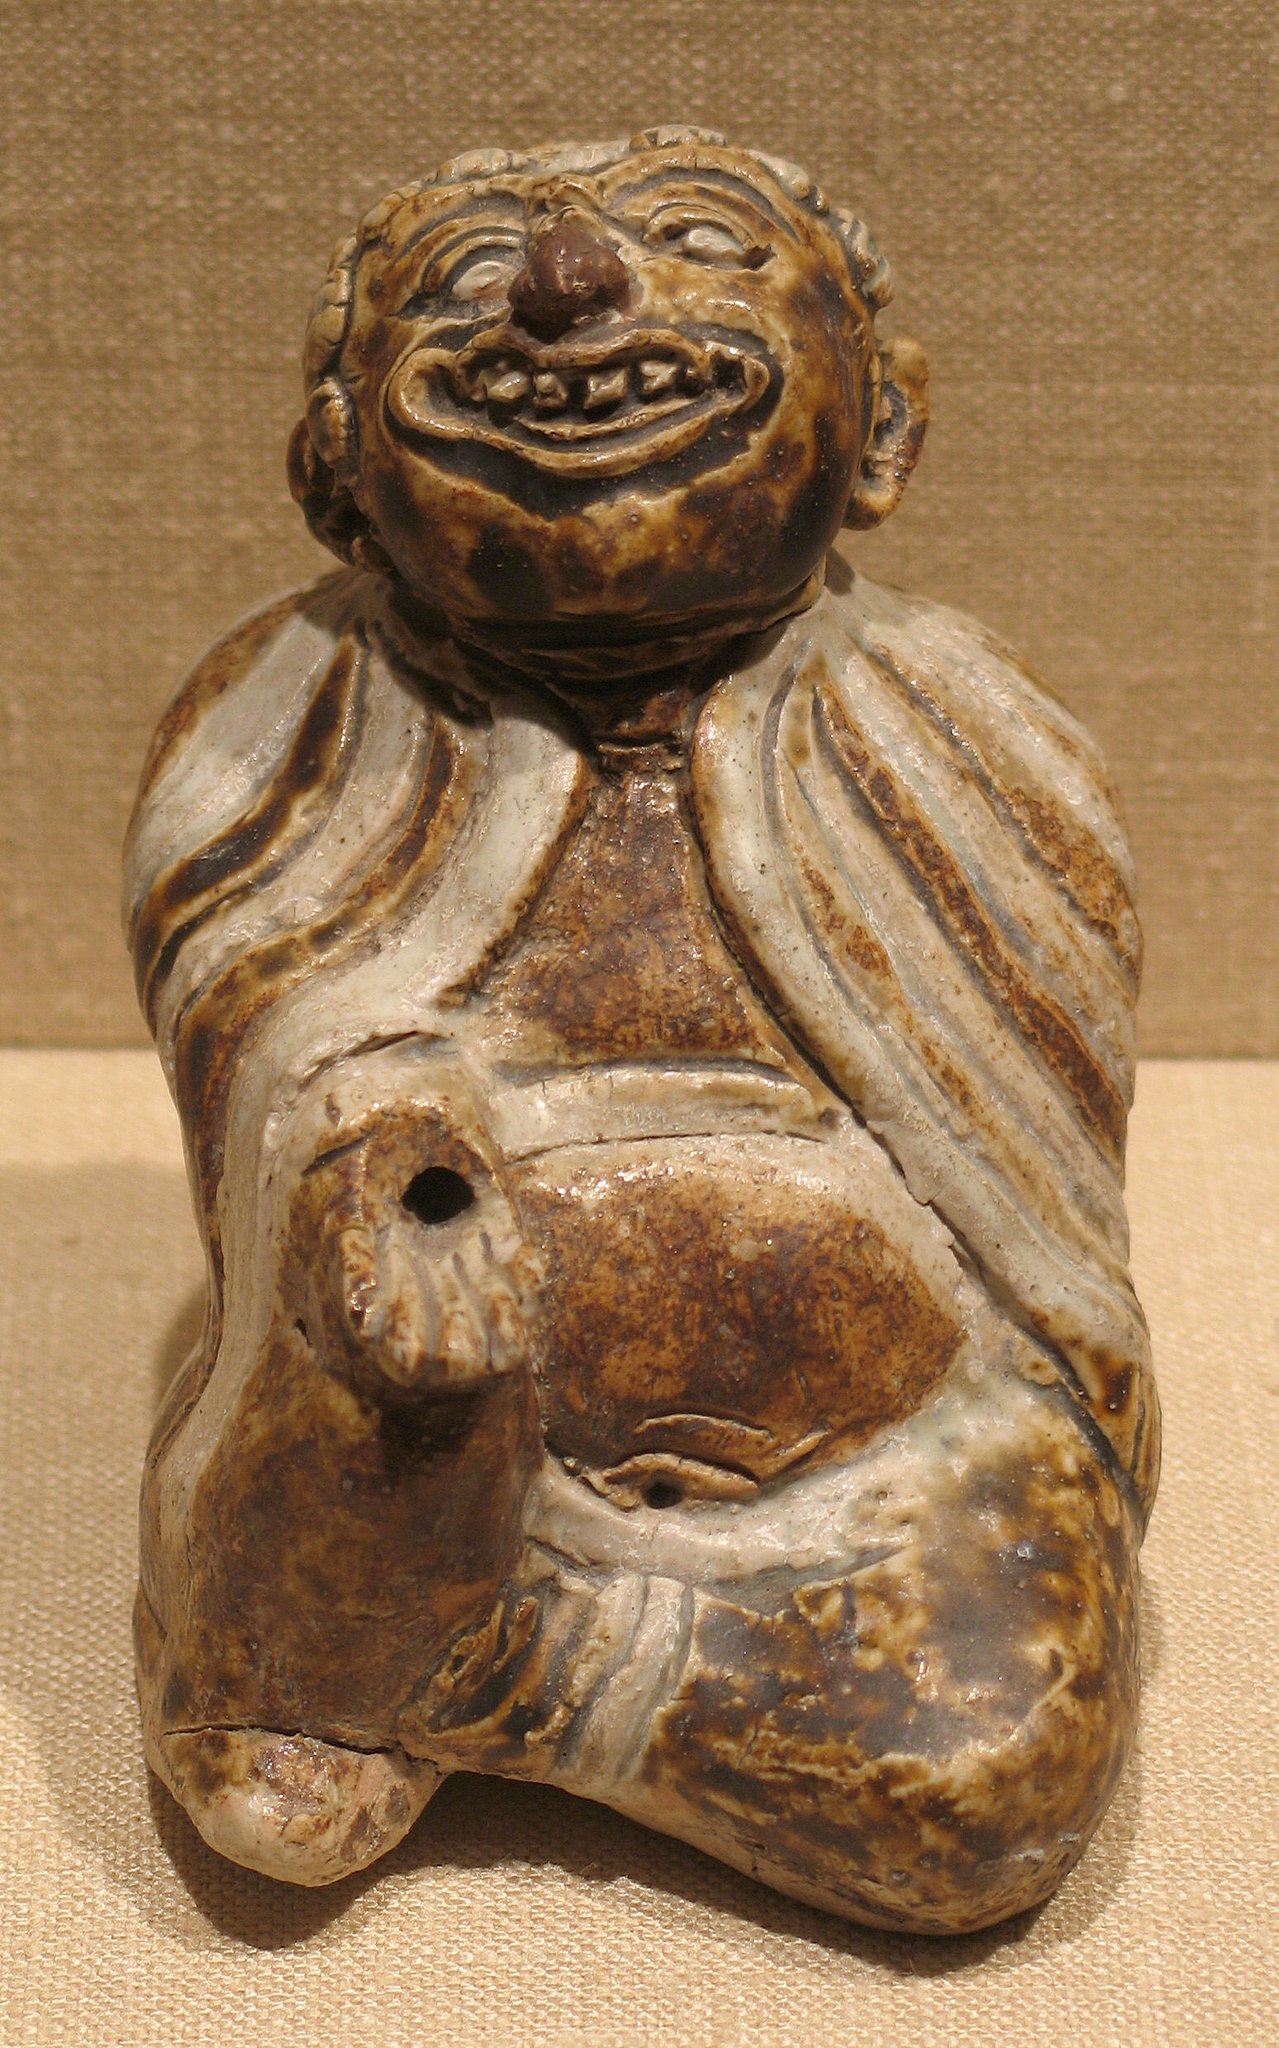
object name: water dropper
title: Water Dropper in the form of a Seated Demon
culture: thai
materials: earthenware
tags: demons